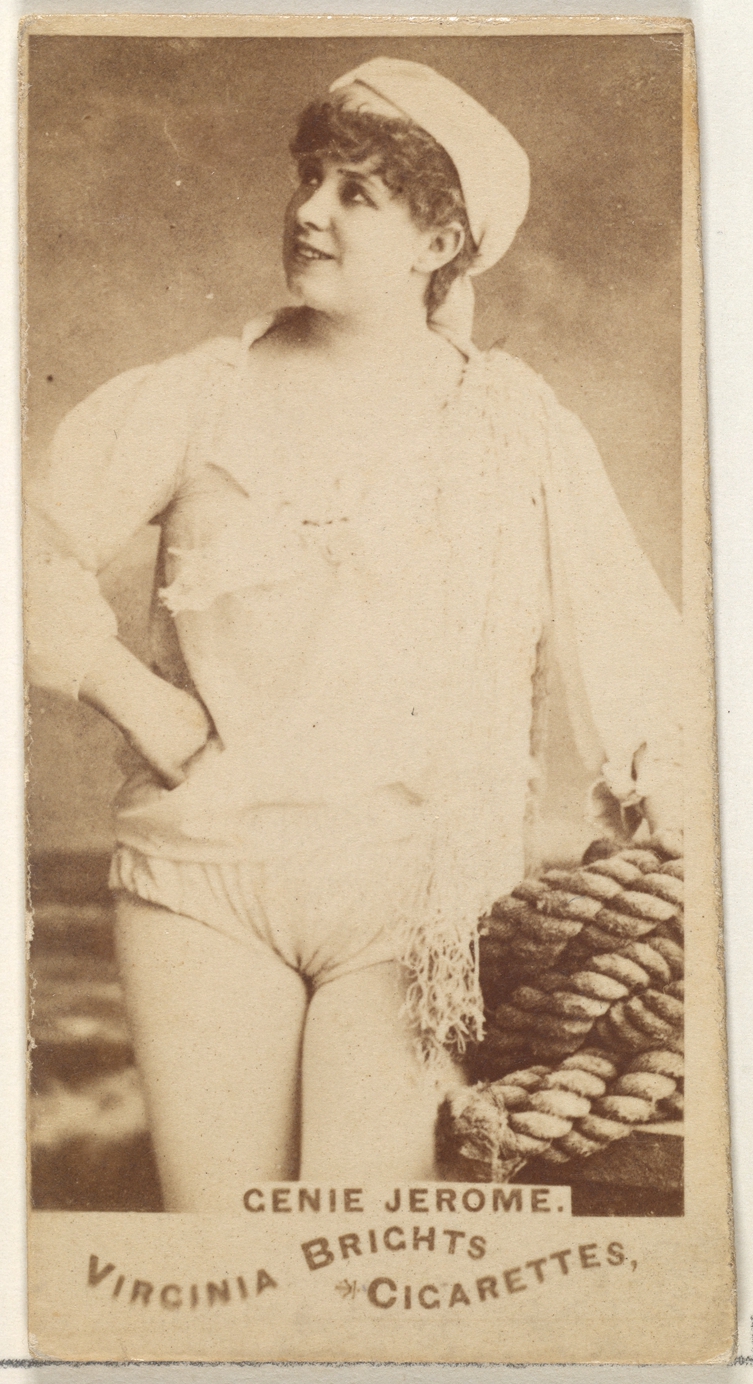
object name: photograph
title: Genie Jerome, from the Actors and Actresses series (N45, Type 1) for Virginia Brights Cigarettes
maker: allen & ginter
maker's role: publisher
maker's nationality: american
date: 1888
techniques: albumen silver print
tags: portraits,women,actresses